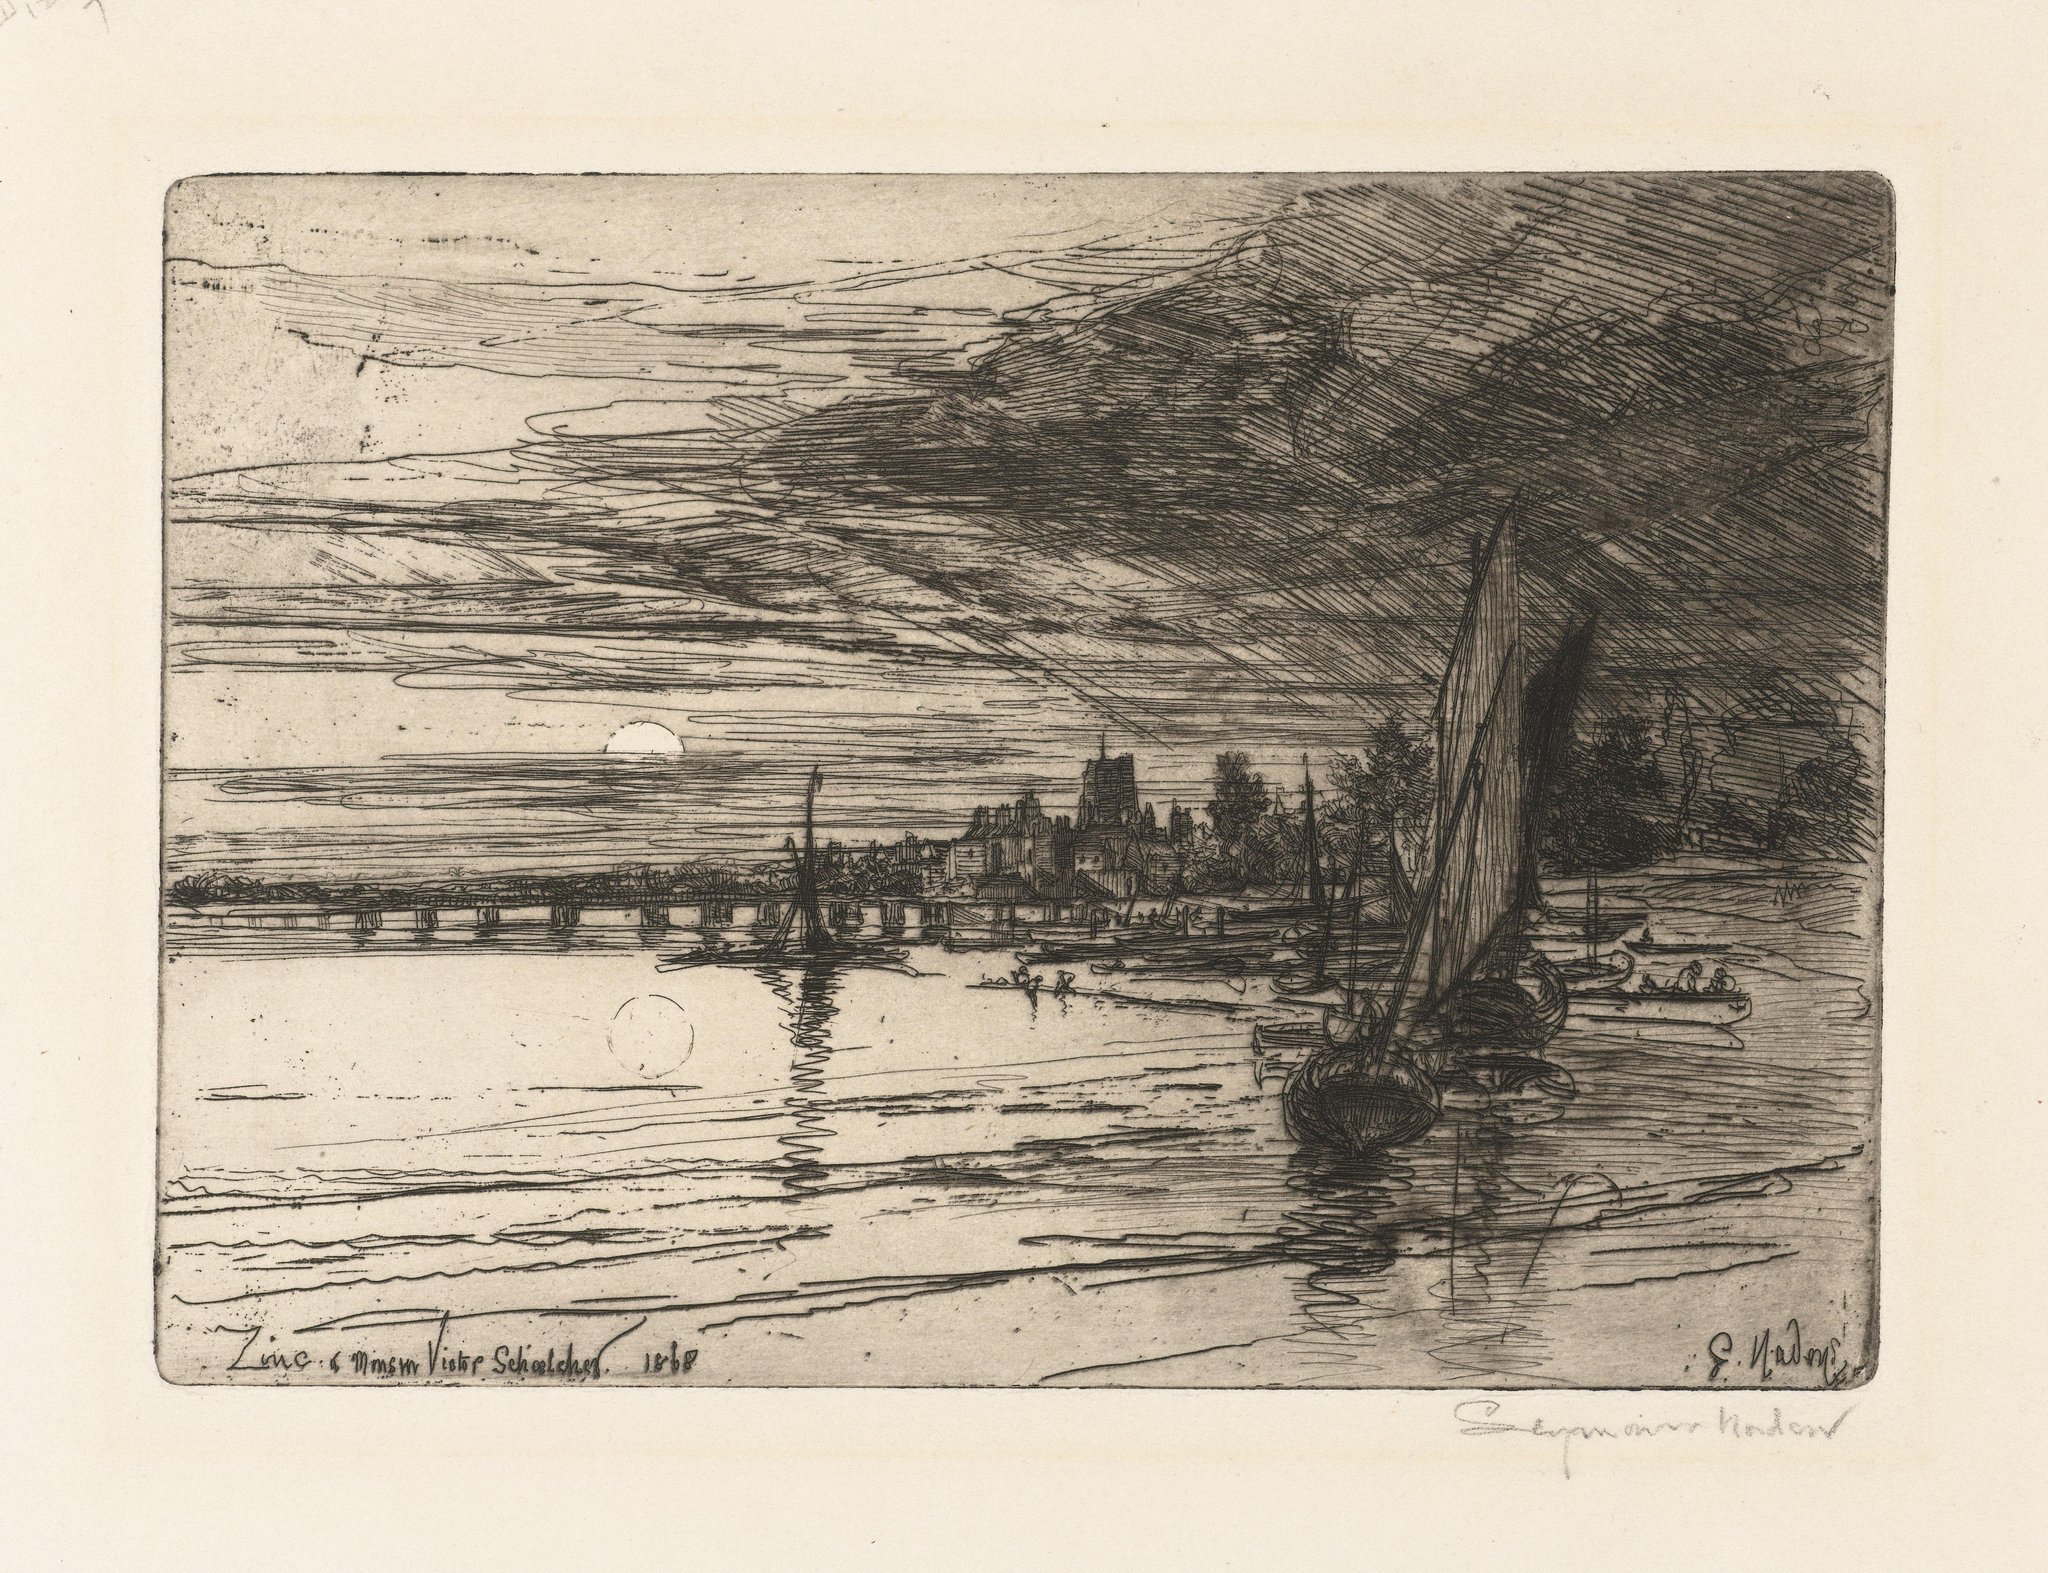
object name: print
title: Brug over de Theems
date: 1868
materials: paper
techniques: drypoint, etching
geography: england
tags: bridge in city across river, canal, etc., thames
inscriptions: signature: ‘Seymour Haden’, inscription: ‘Zinc. A monsieur Victor Schoelcher 1868’, collector's mark, collector's mark: Lugt 2228, collector's mark: Lugt 2760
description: De rivier de Theems bij volle maan. Aan de horizon de Battersea brug over het water, en de kerk en huizen van Chelsea.